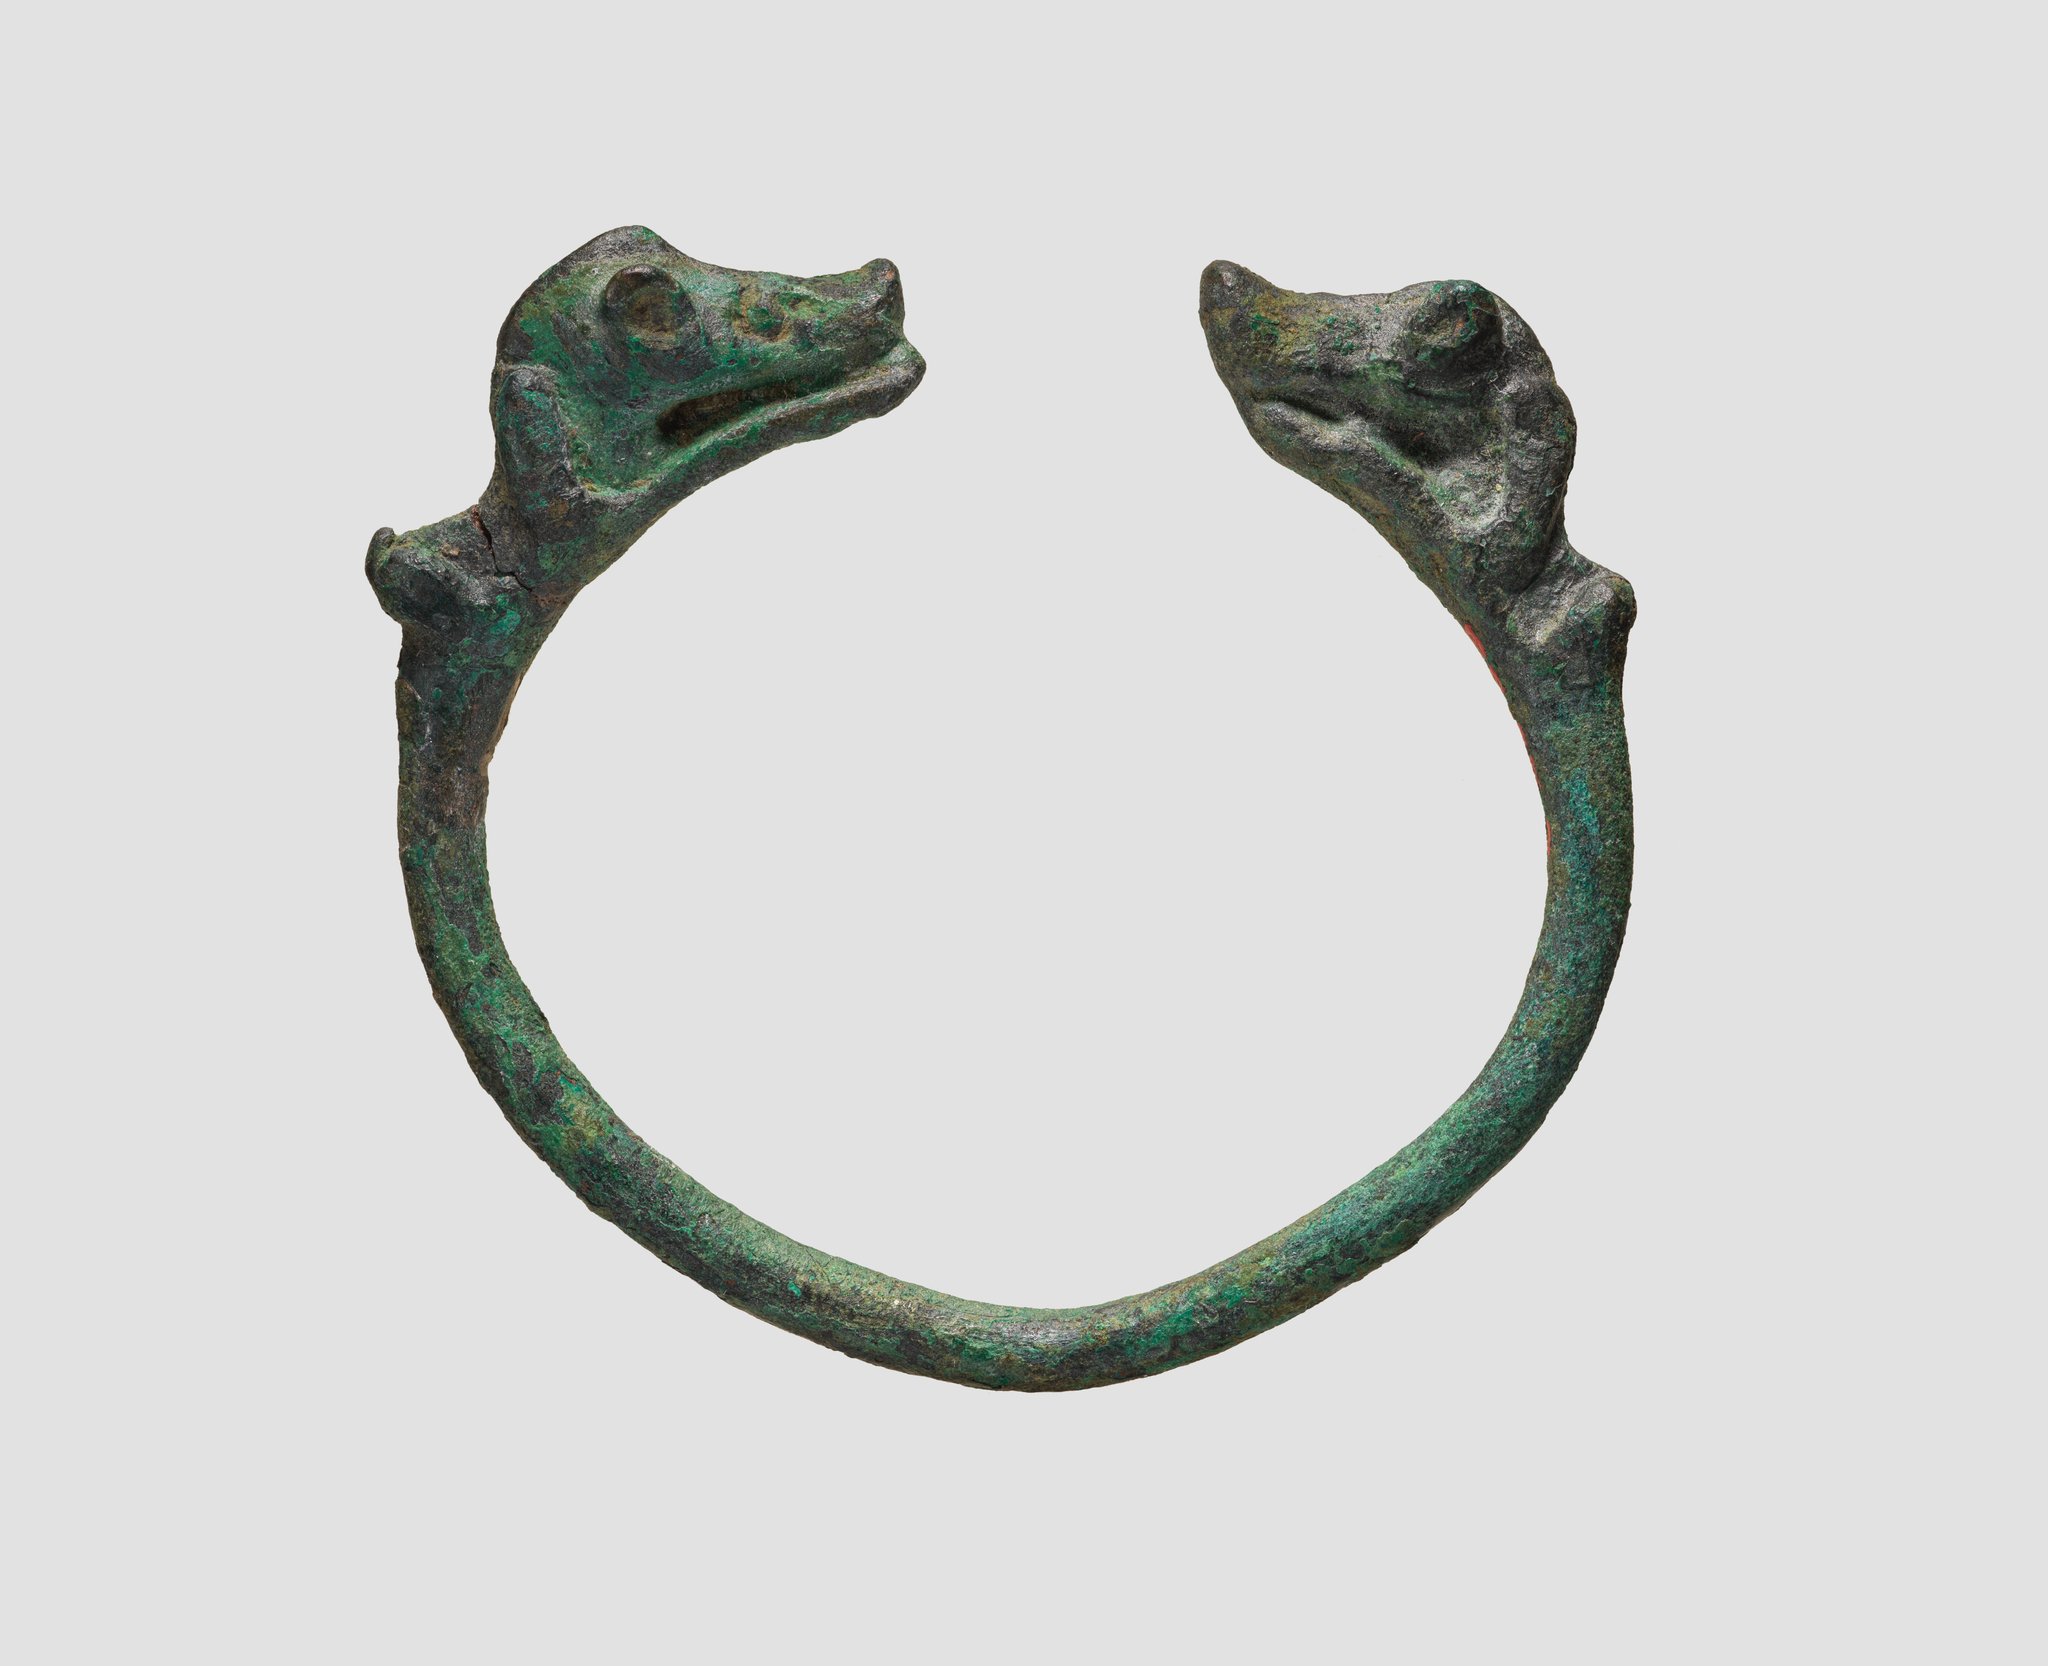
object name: bracelet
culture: iranian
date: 800-601 BCE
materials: bronze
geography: iran, probably from luristan